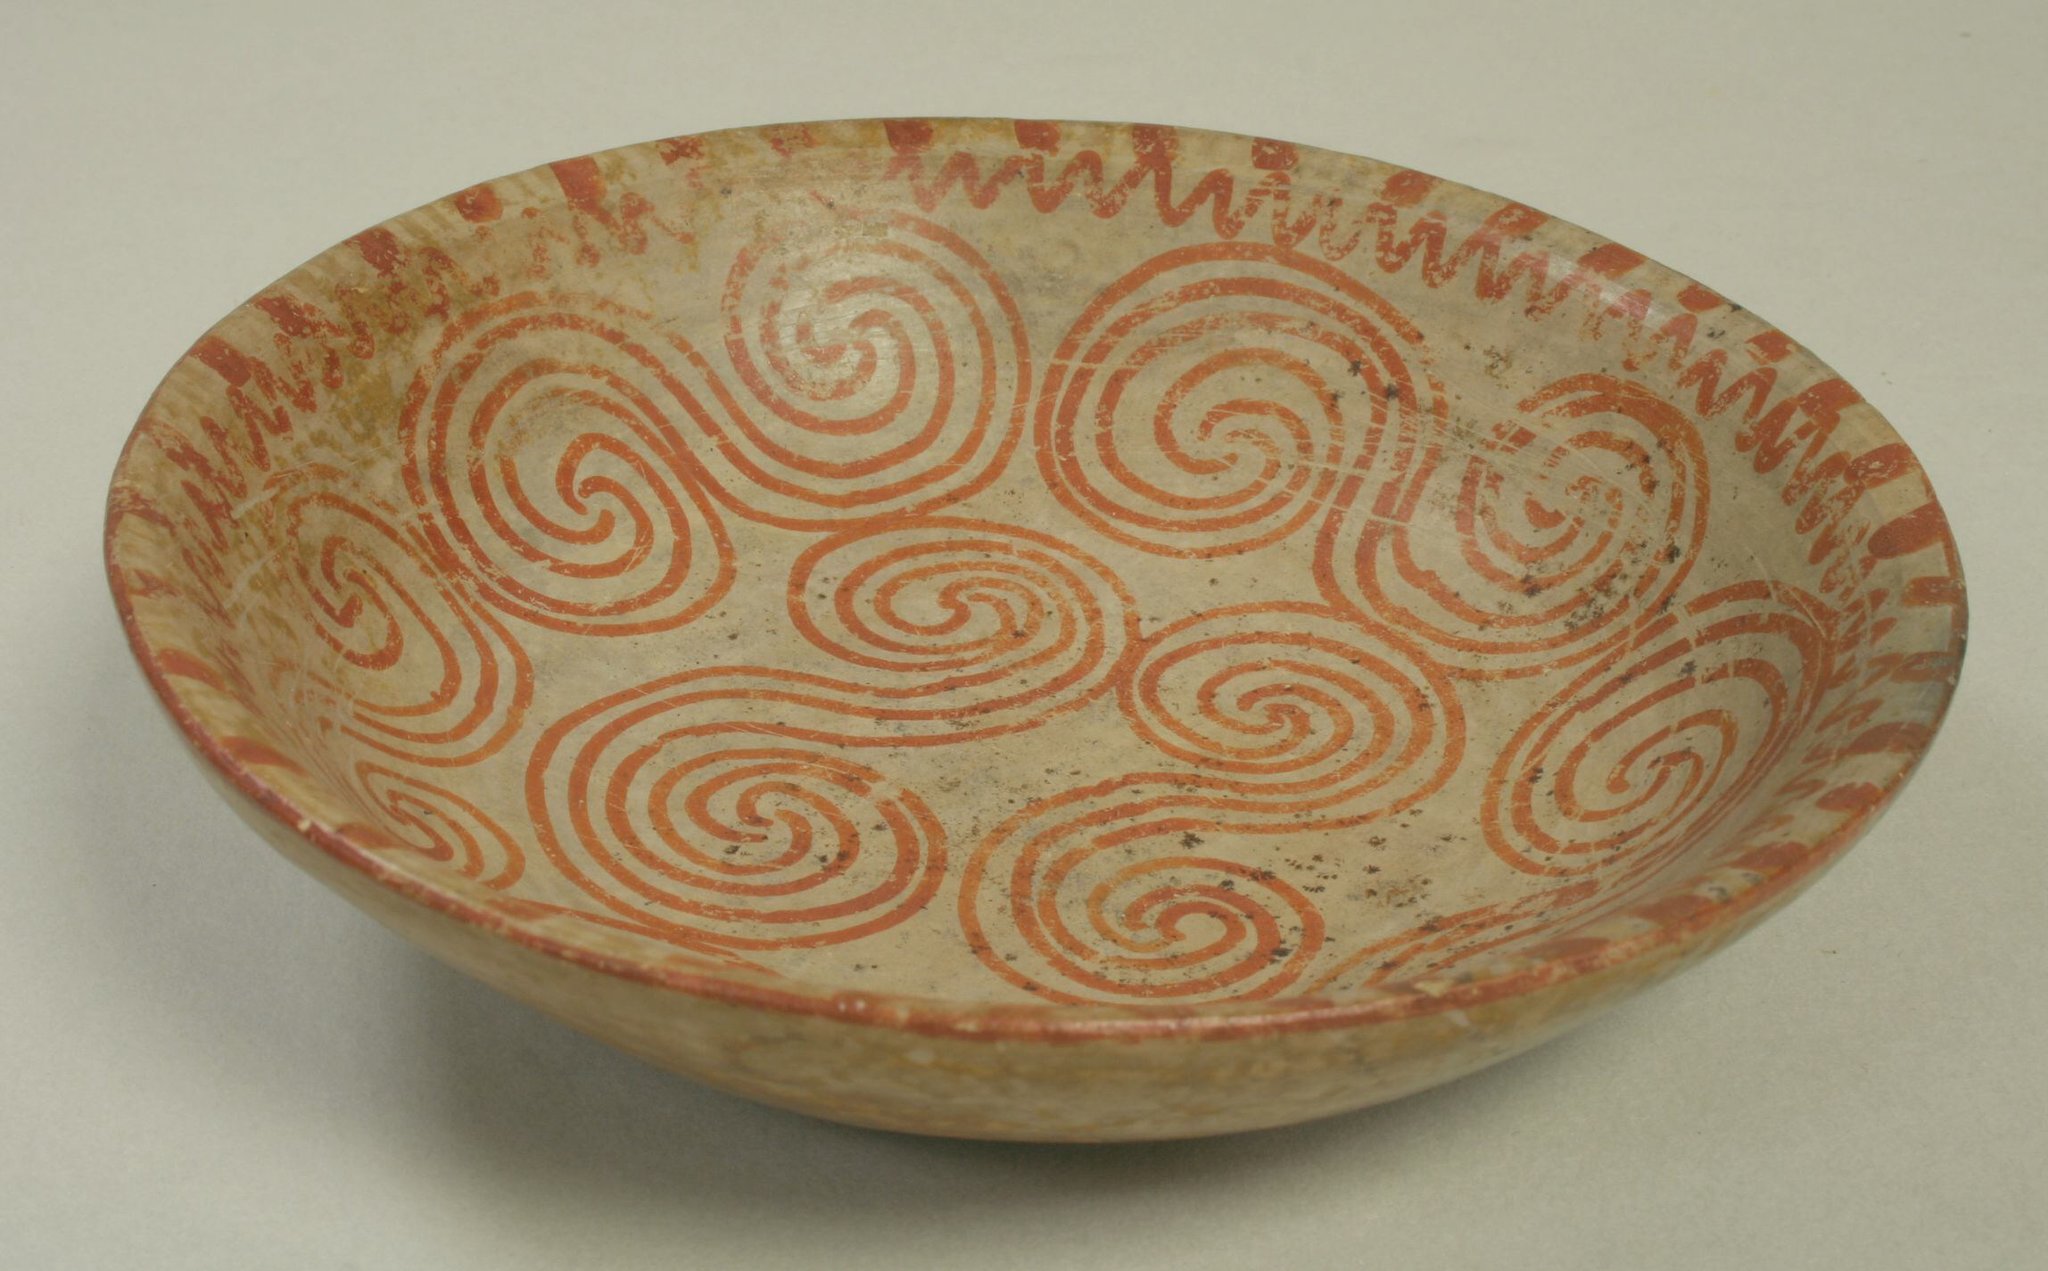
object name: bowl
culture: cajamarca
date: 301-700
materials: ceramic, pigment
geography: peru